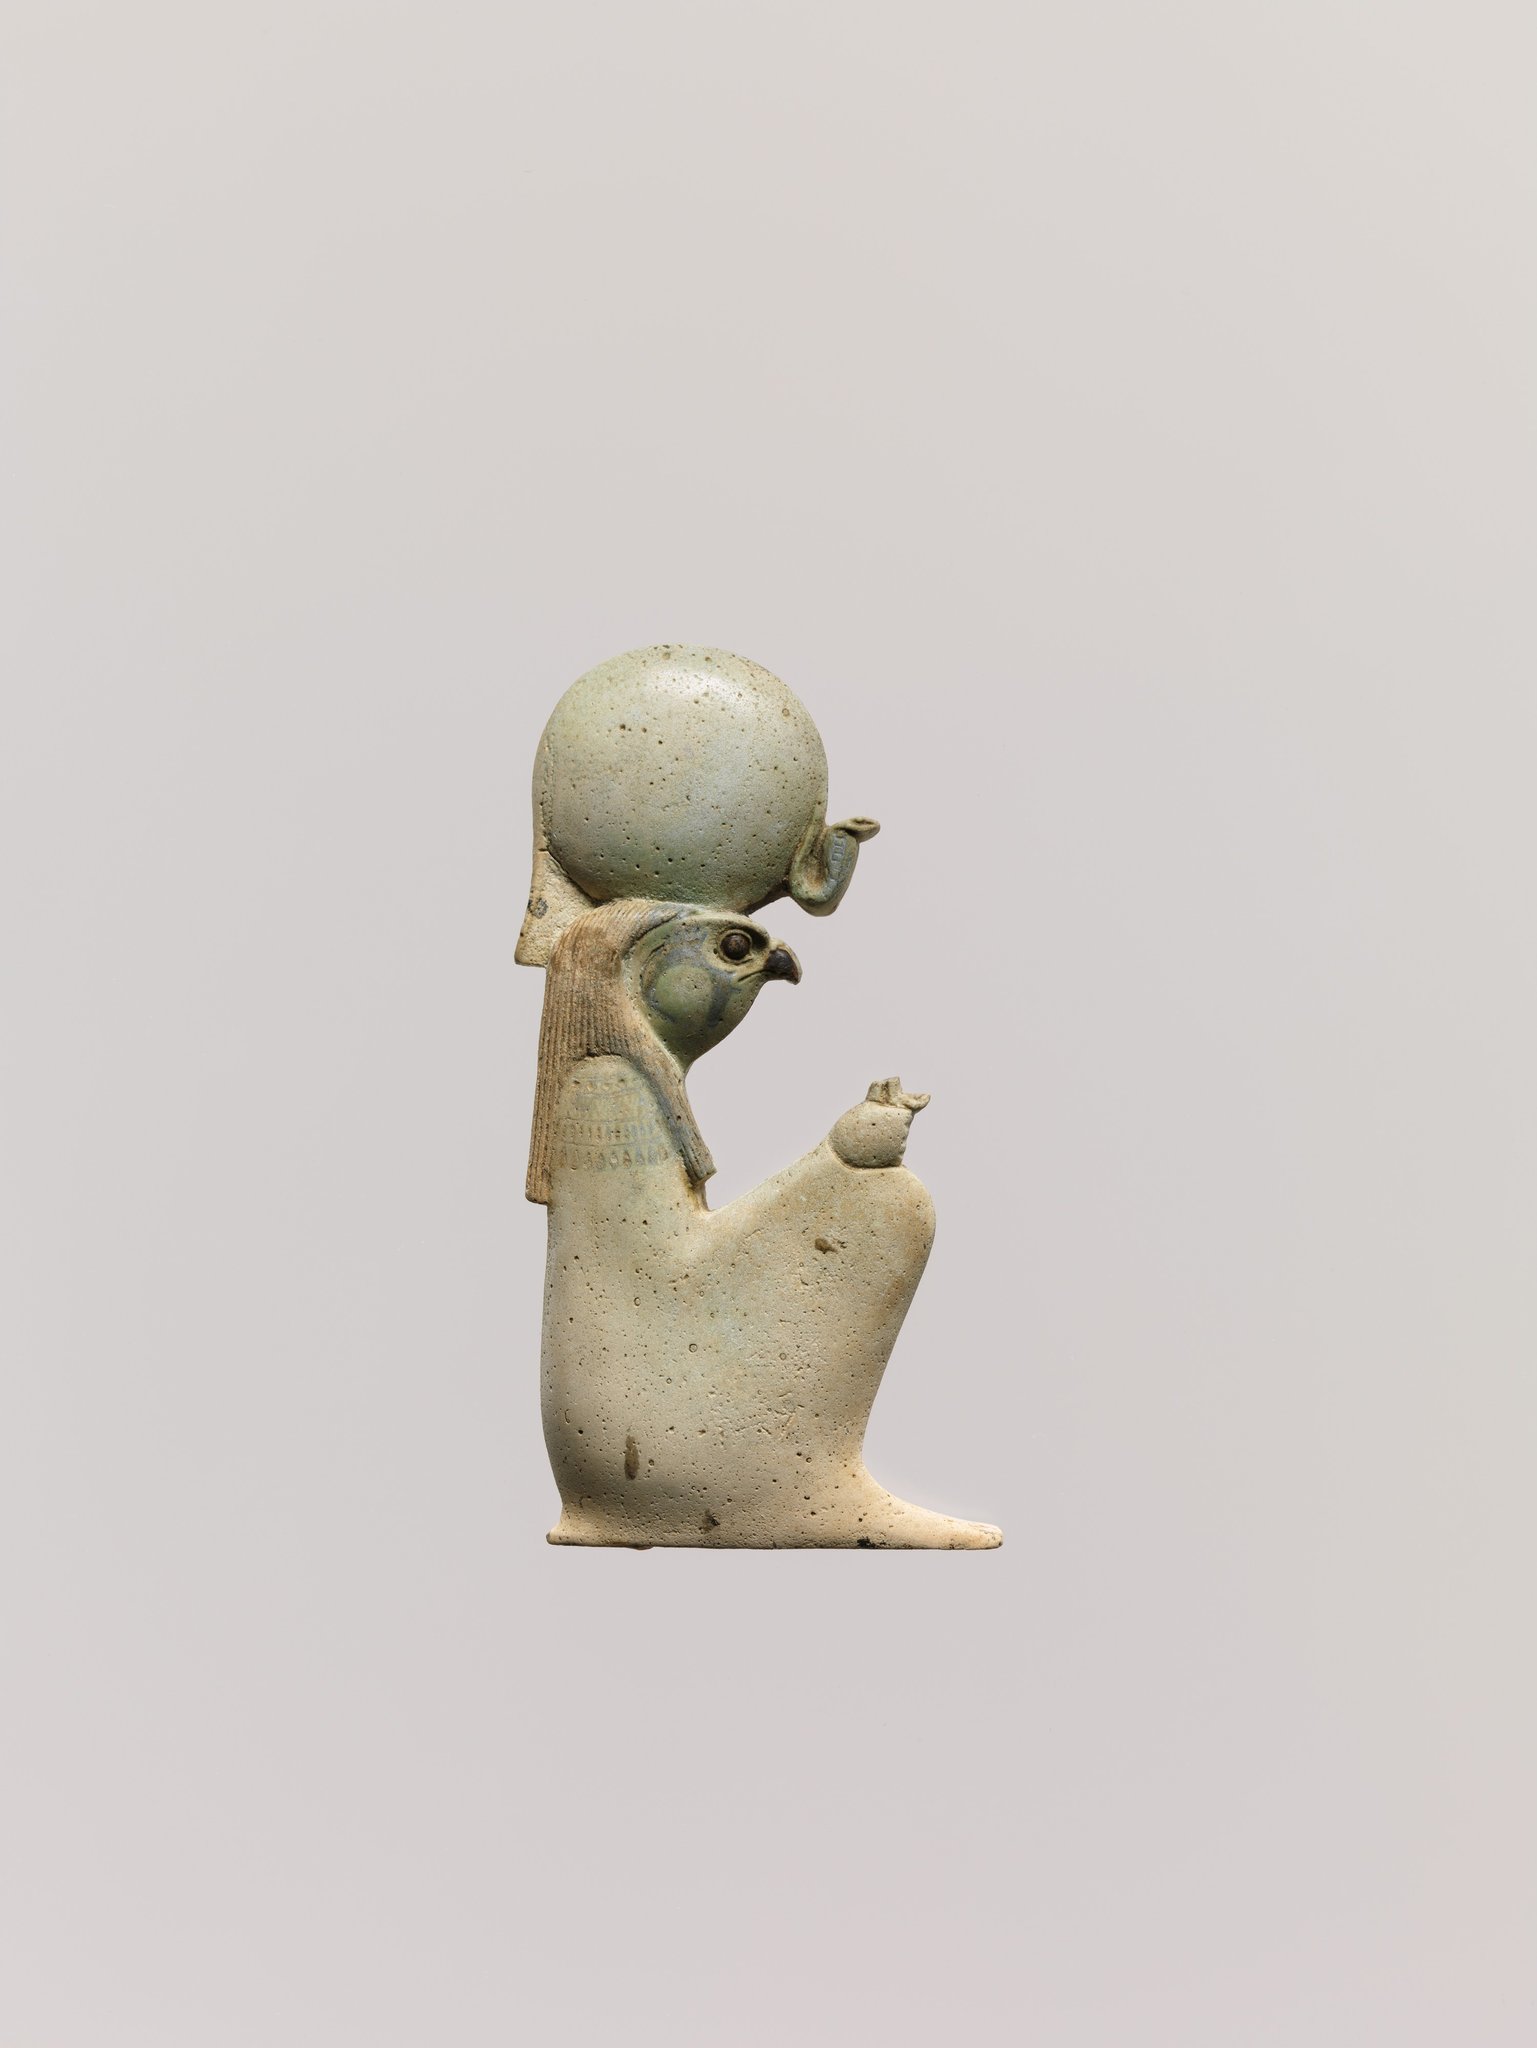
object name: inlay, squatting figure, falcon head, sun disk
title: Inlay depicting the squatting god Re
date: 360-343 BCE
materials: faience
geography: middle egypt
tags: falcons